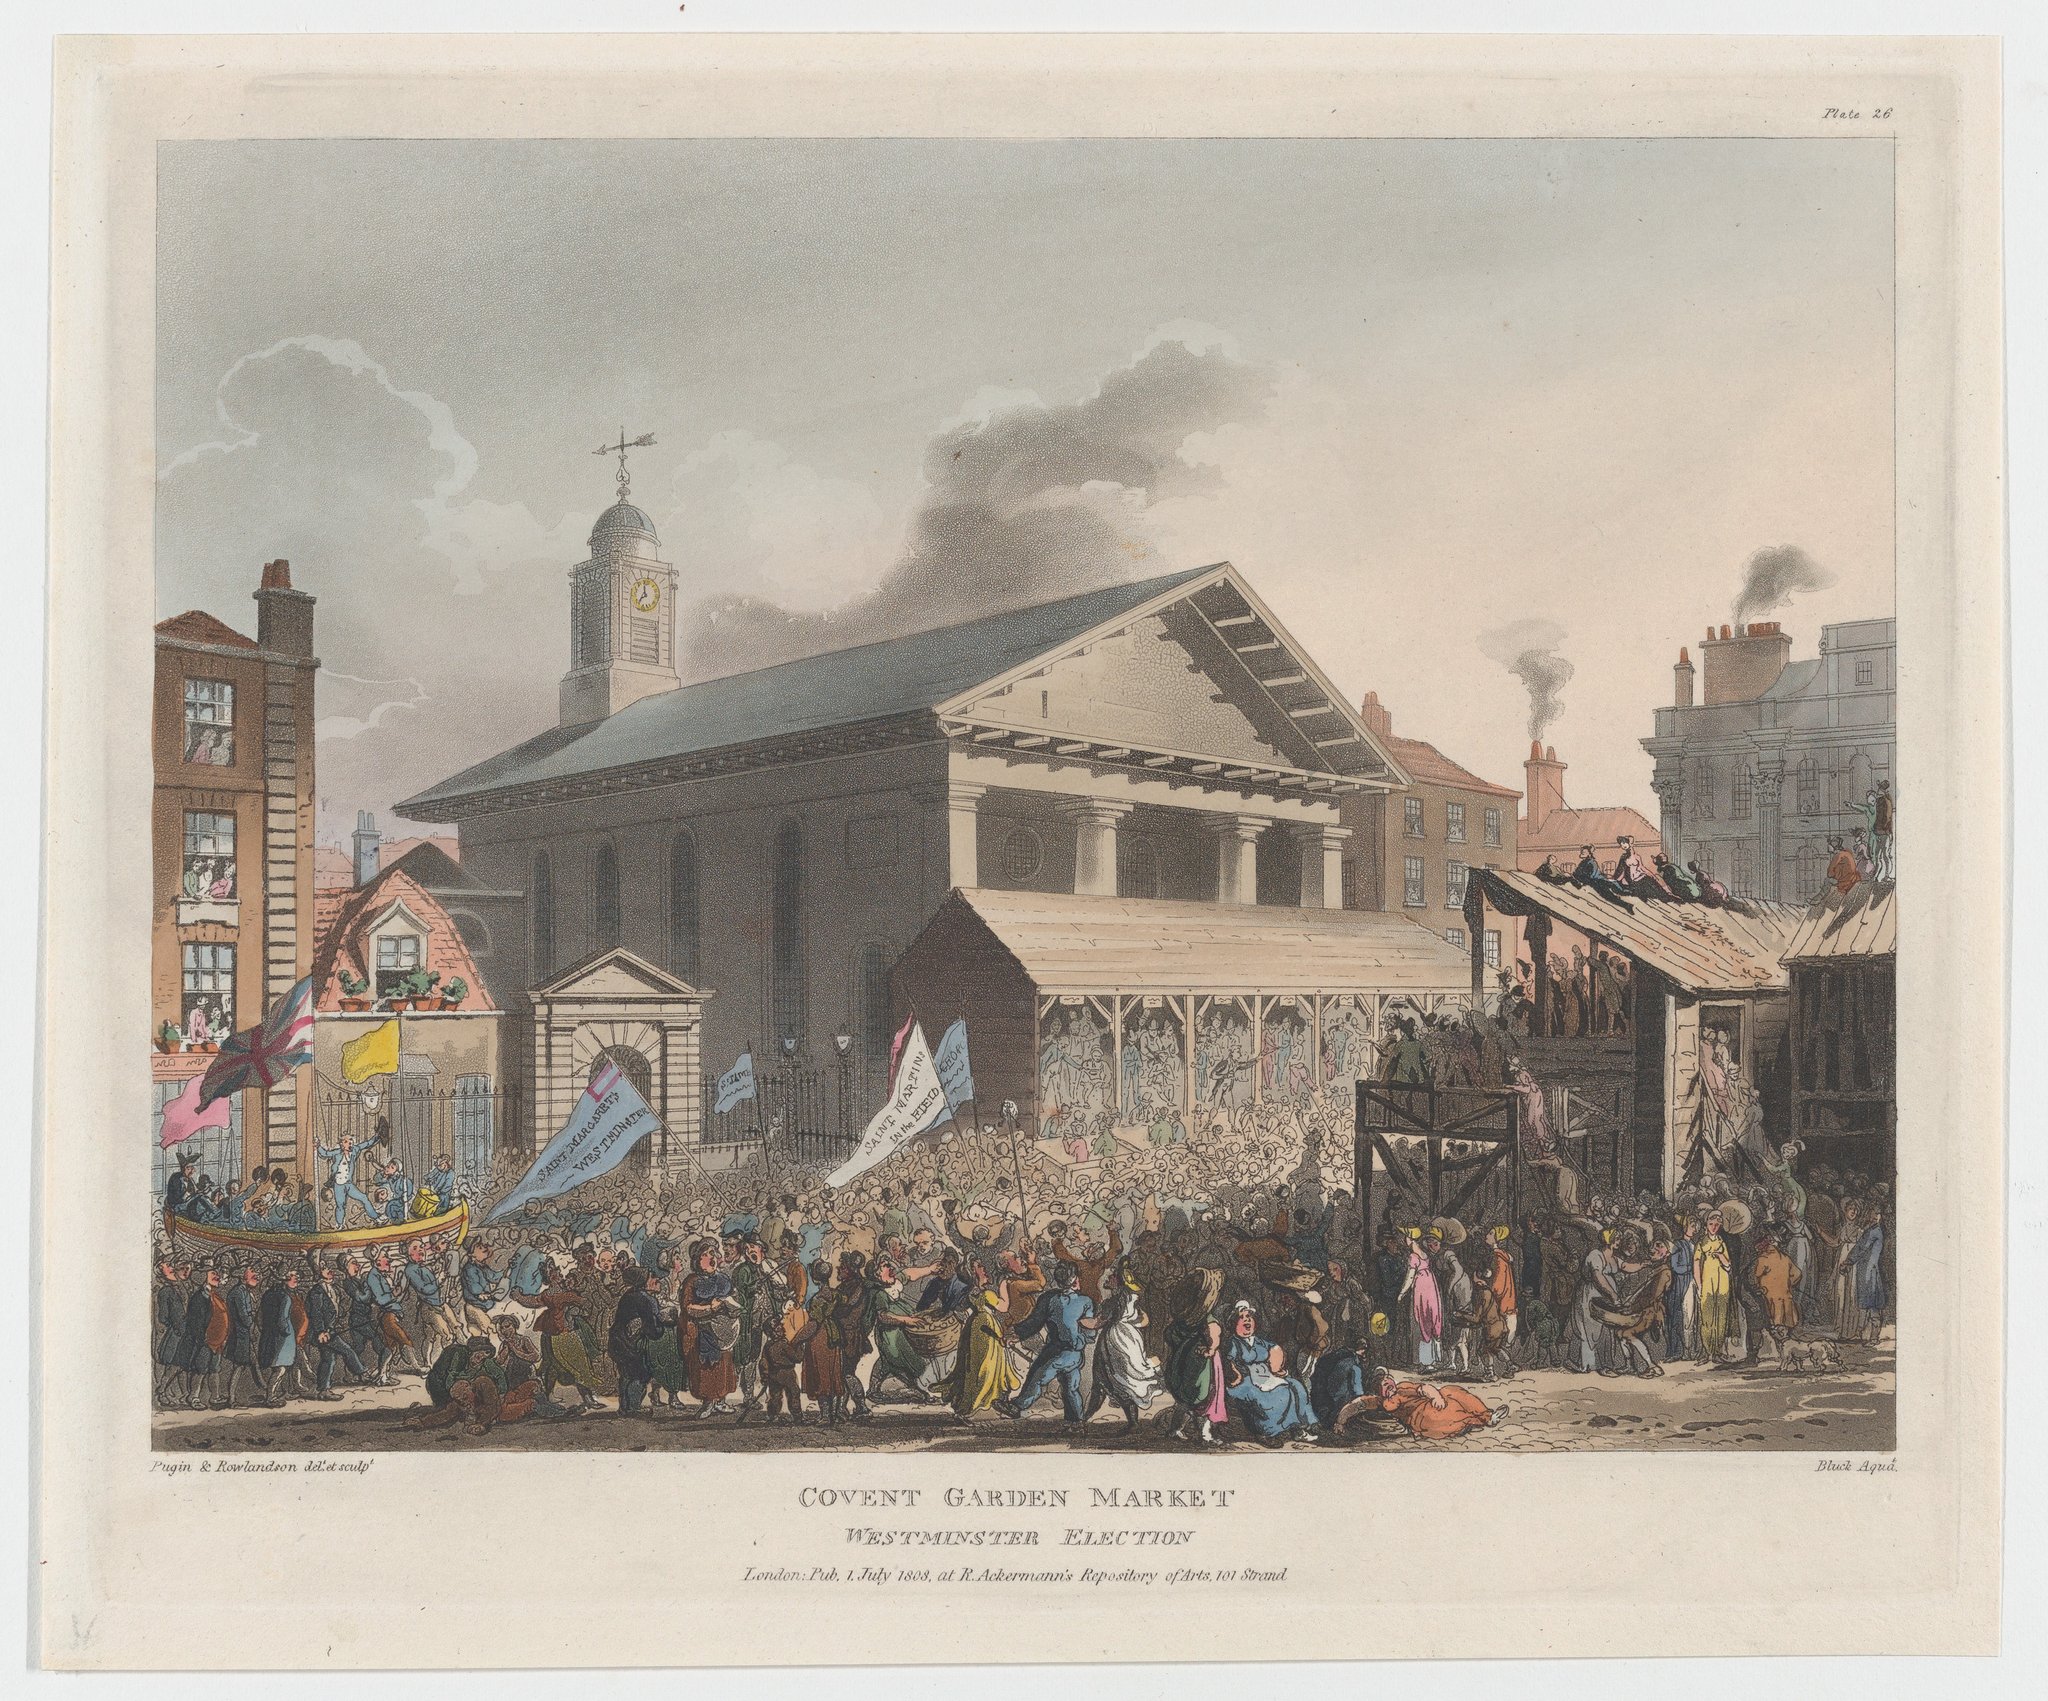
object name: print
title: Covent Garden Market, Westminster Election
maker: thomas rowlandson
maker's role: artist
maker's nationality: british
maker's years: 1757-1827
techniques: aquatint, etching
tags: elections,crowd,markets,london